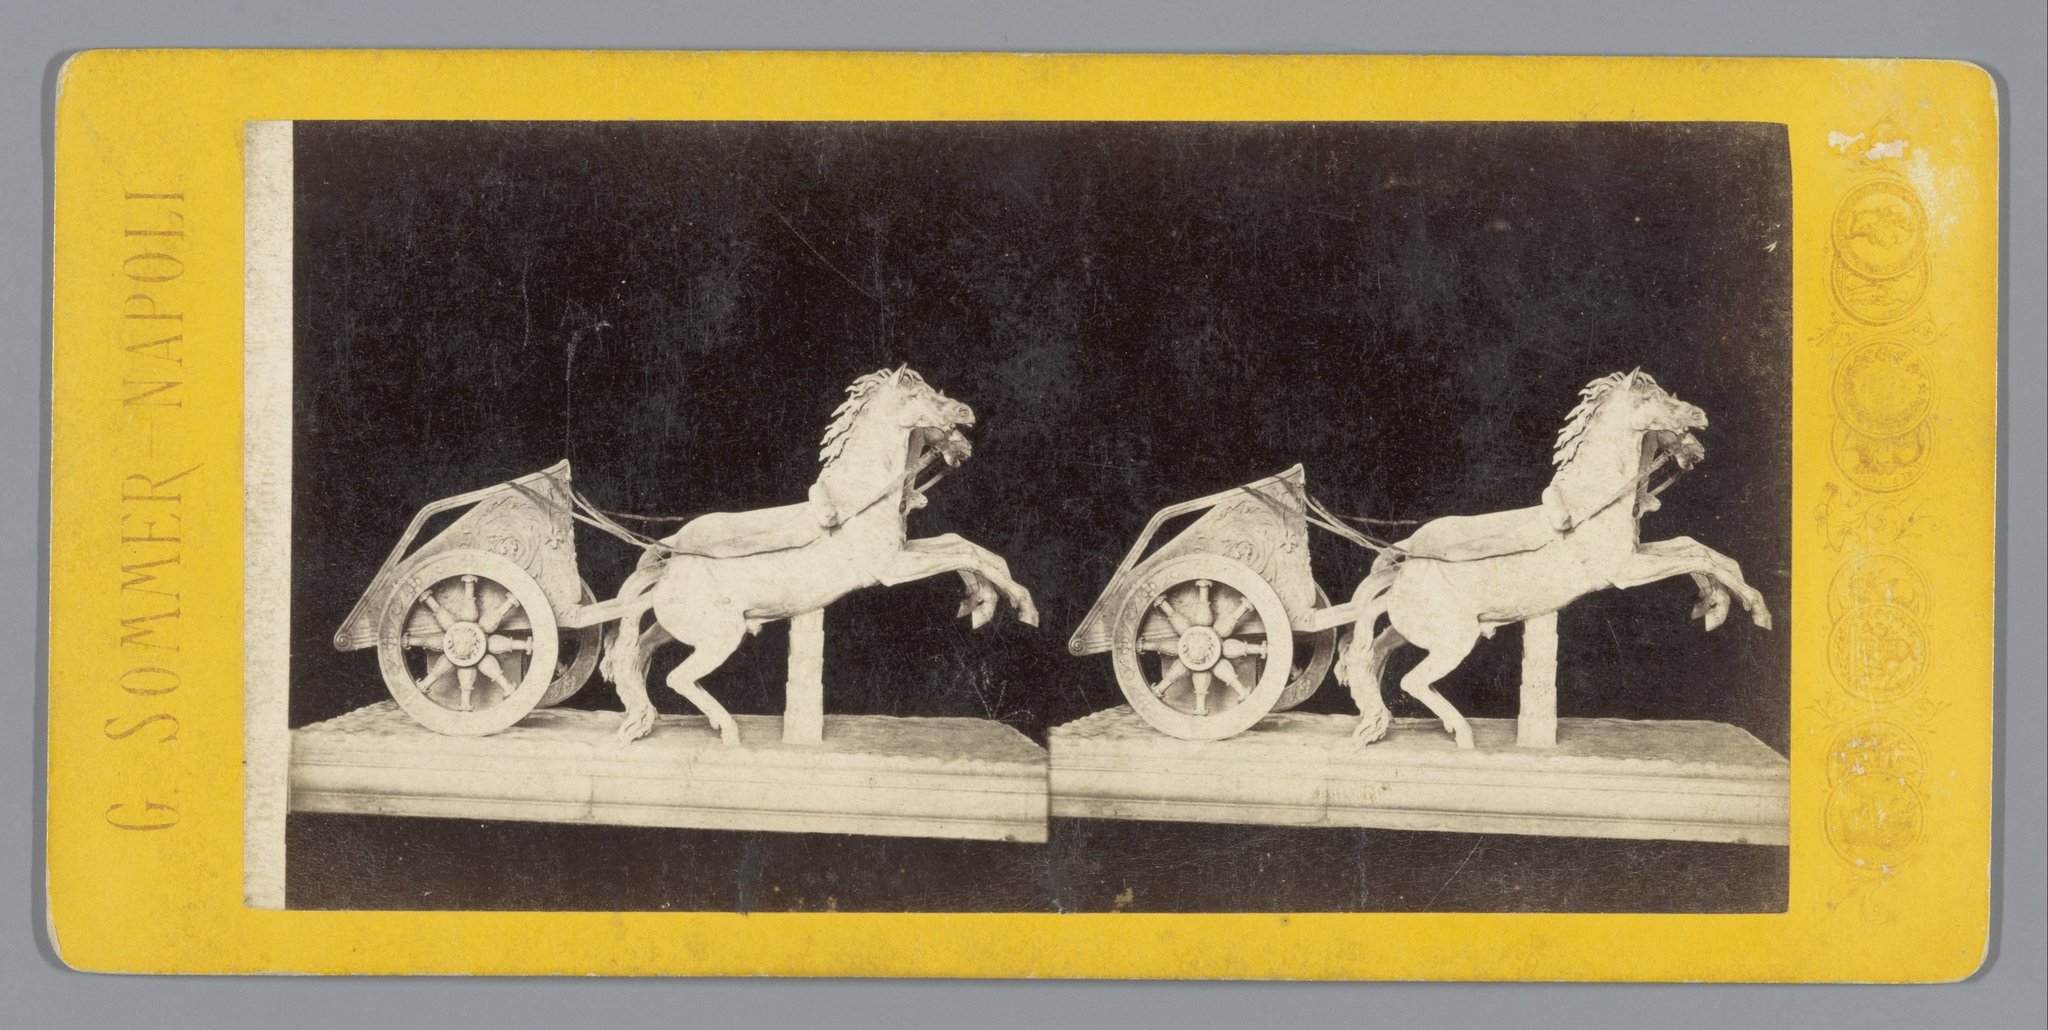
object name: stereograph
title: Sculptuur van een strijdwagen met twee paarden in de Vaticaanse Musea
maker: giorgio sommer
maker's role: fotograaf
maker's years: 1834-1914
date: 1860-1880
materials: cardboard, photographic support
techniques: albumen print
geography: vatican museums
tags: chariot, triumphal car, piece of sculpture, reproduction of a piece of sculpture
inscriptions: inscription, inscription: ‘Rome: Vaticaan’